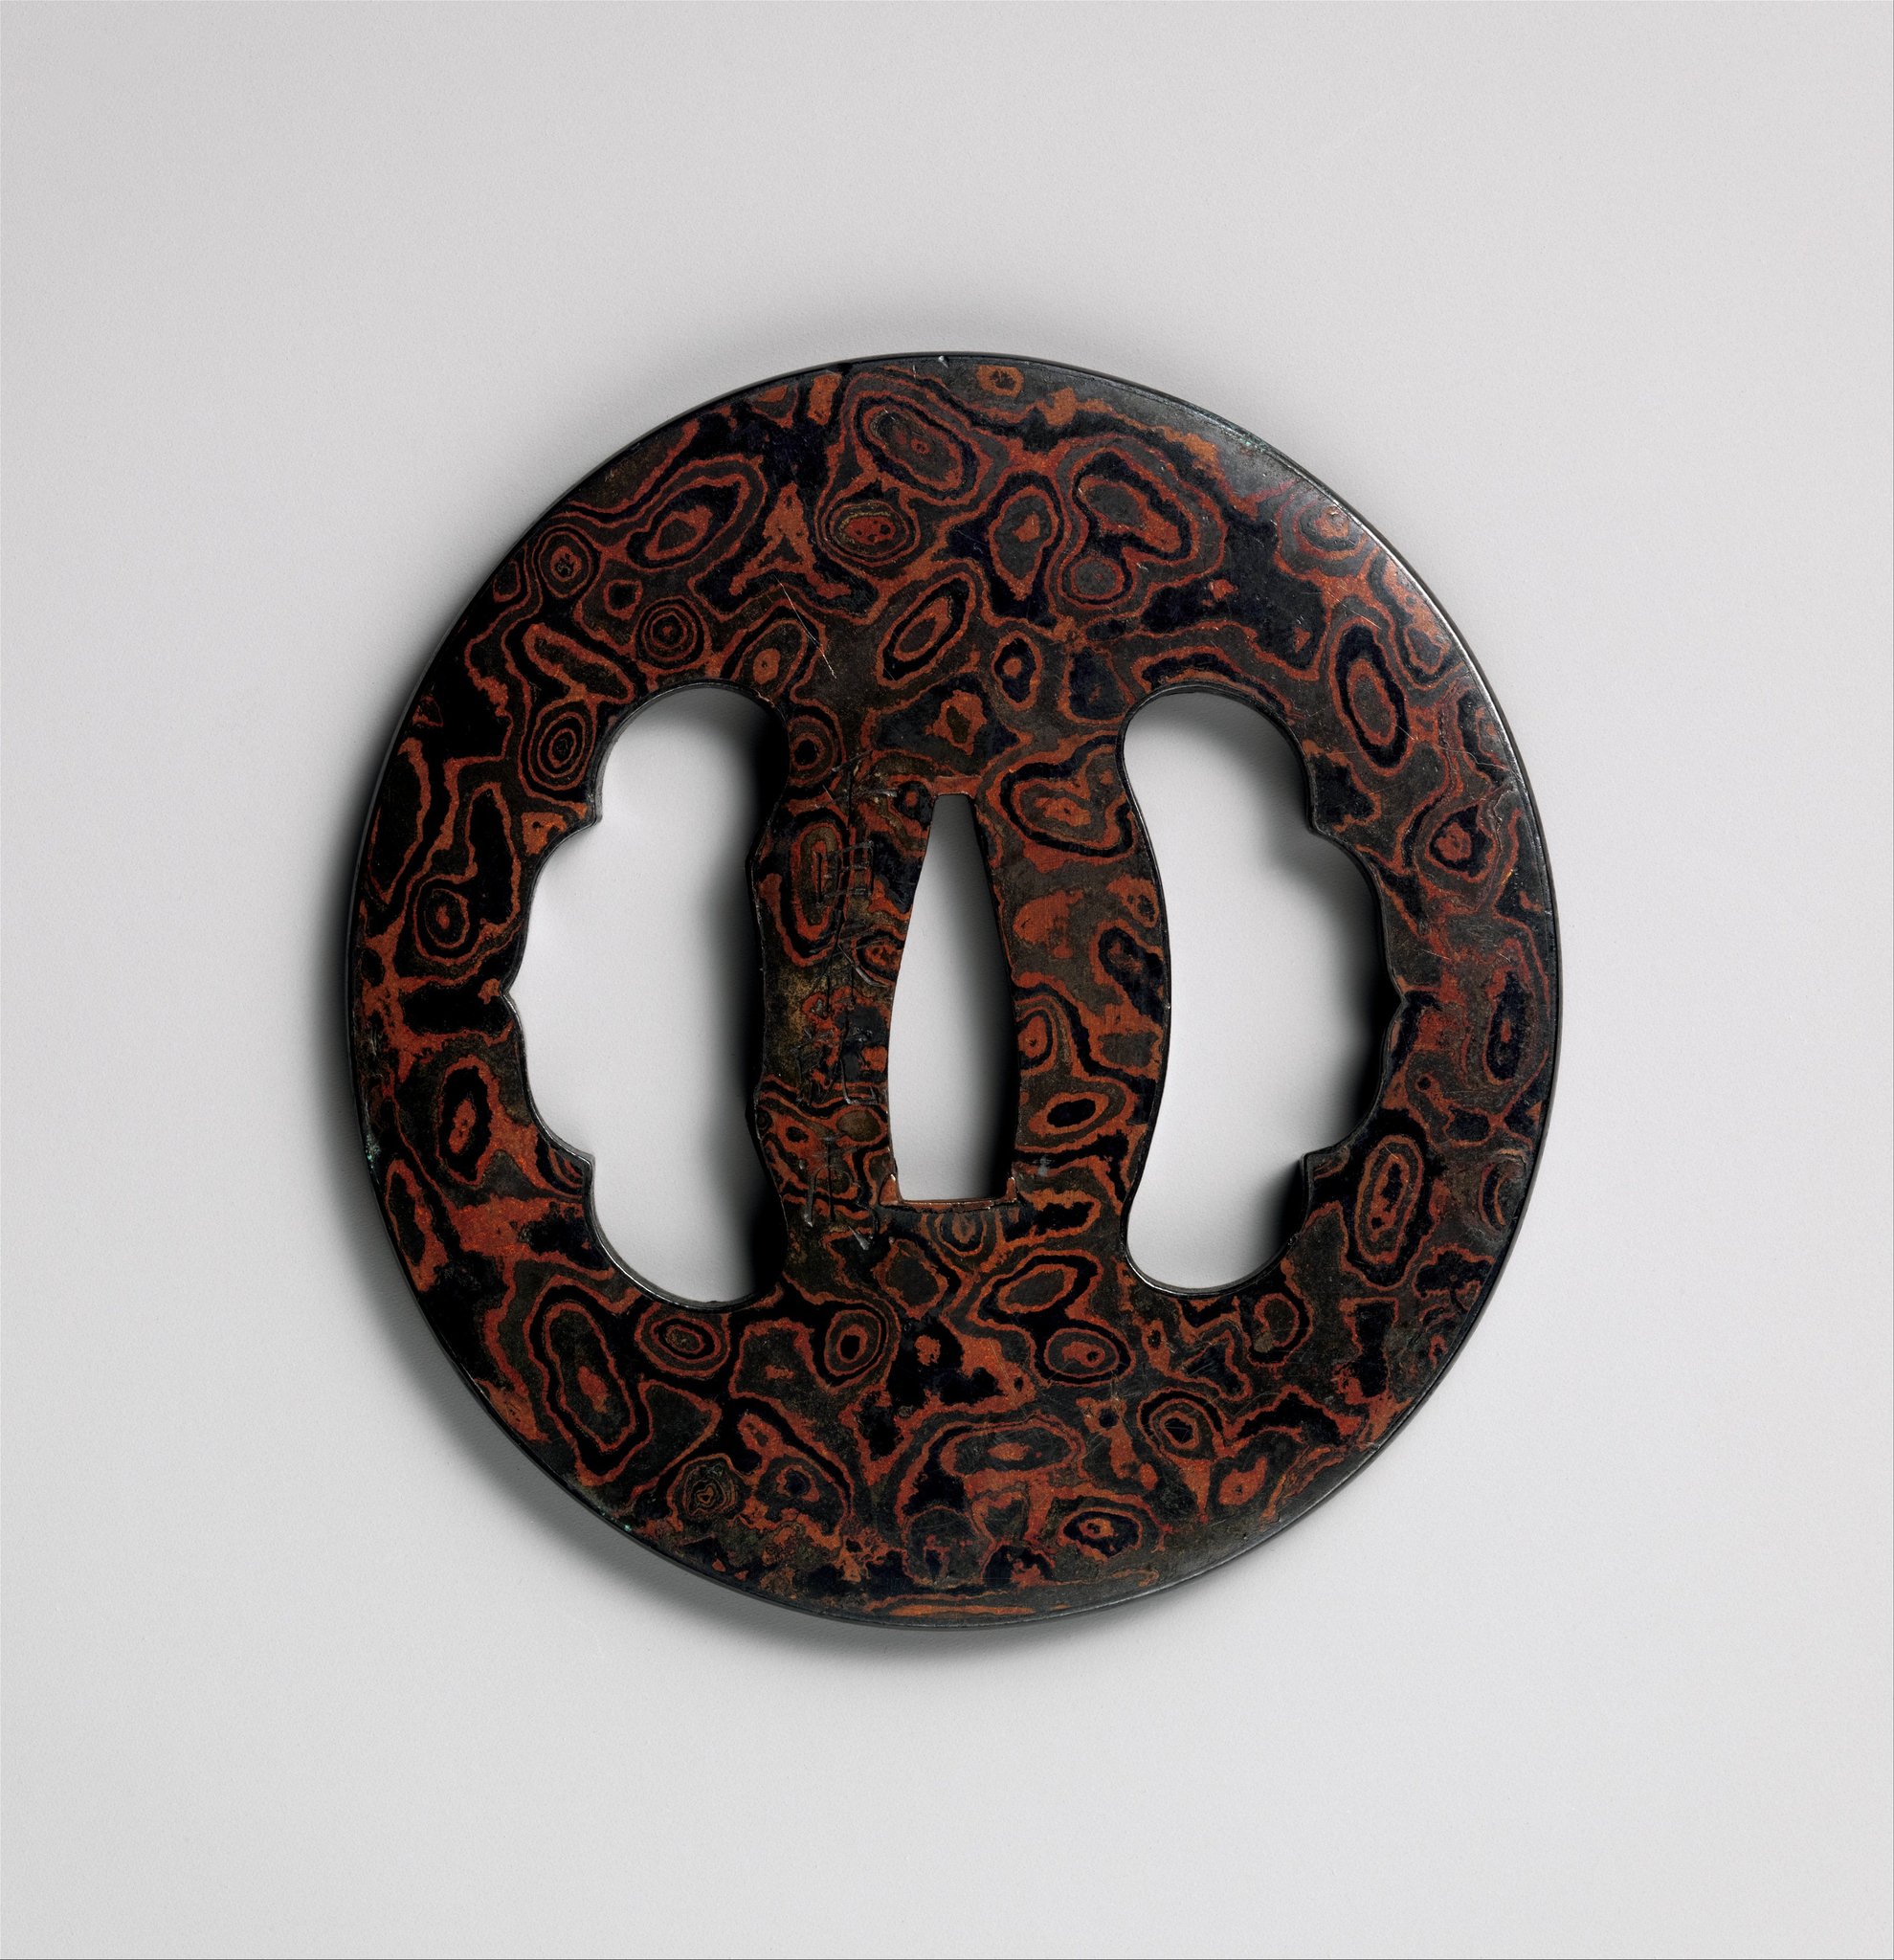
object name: sword guard tsuba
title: Sword Guard (Tsuba)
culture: japanese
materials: copper, gold alloy, iron, metal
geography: japan